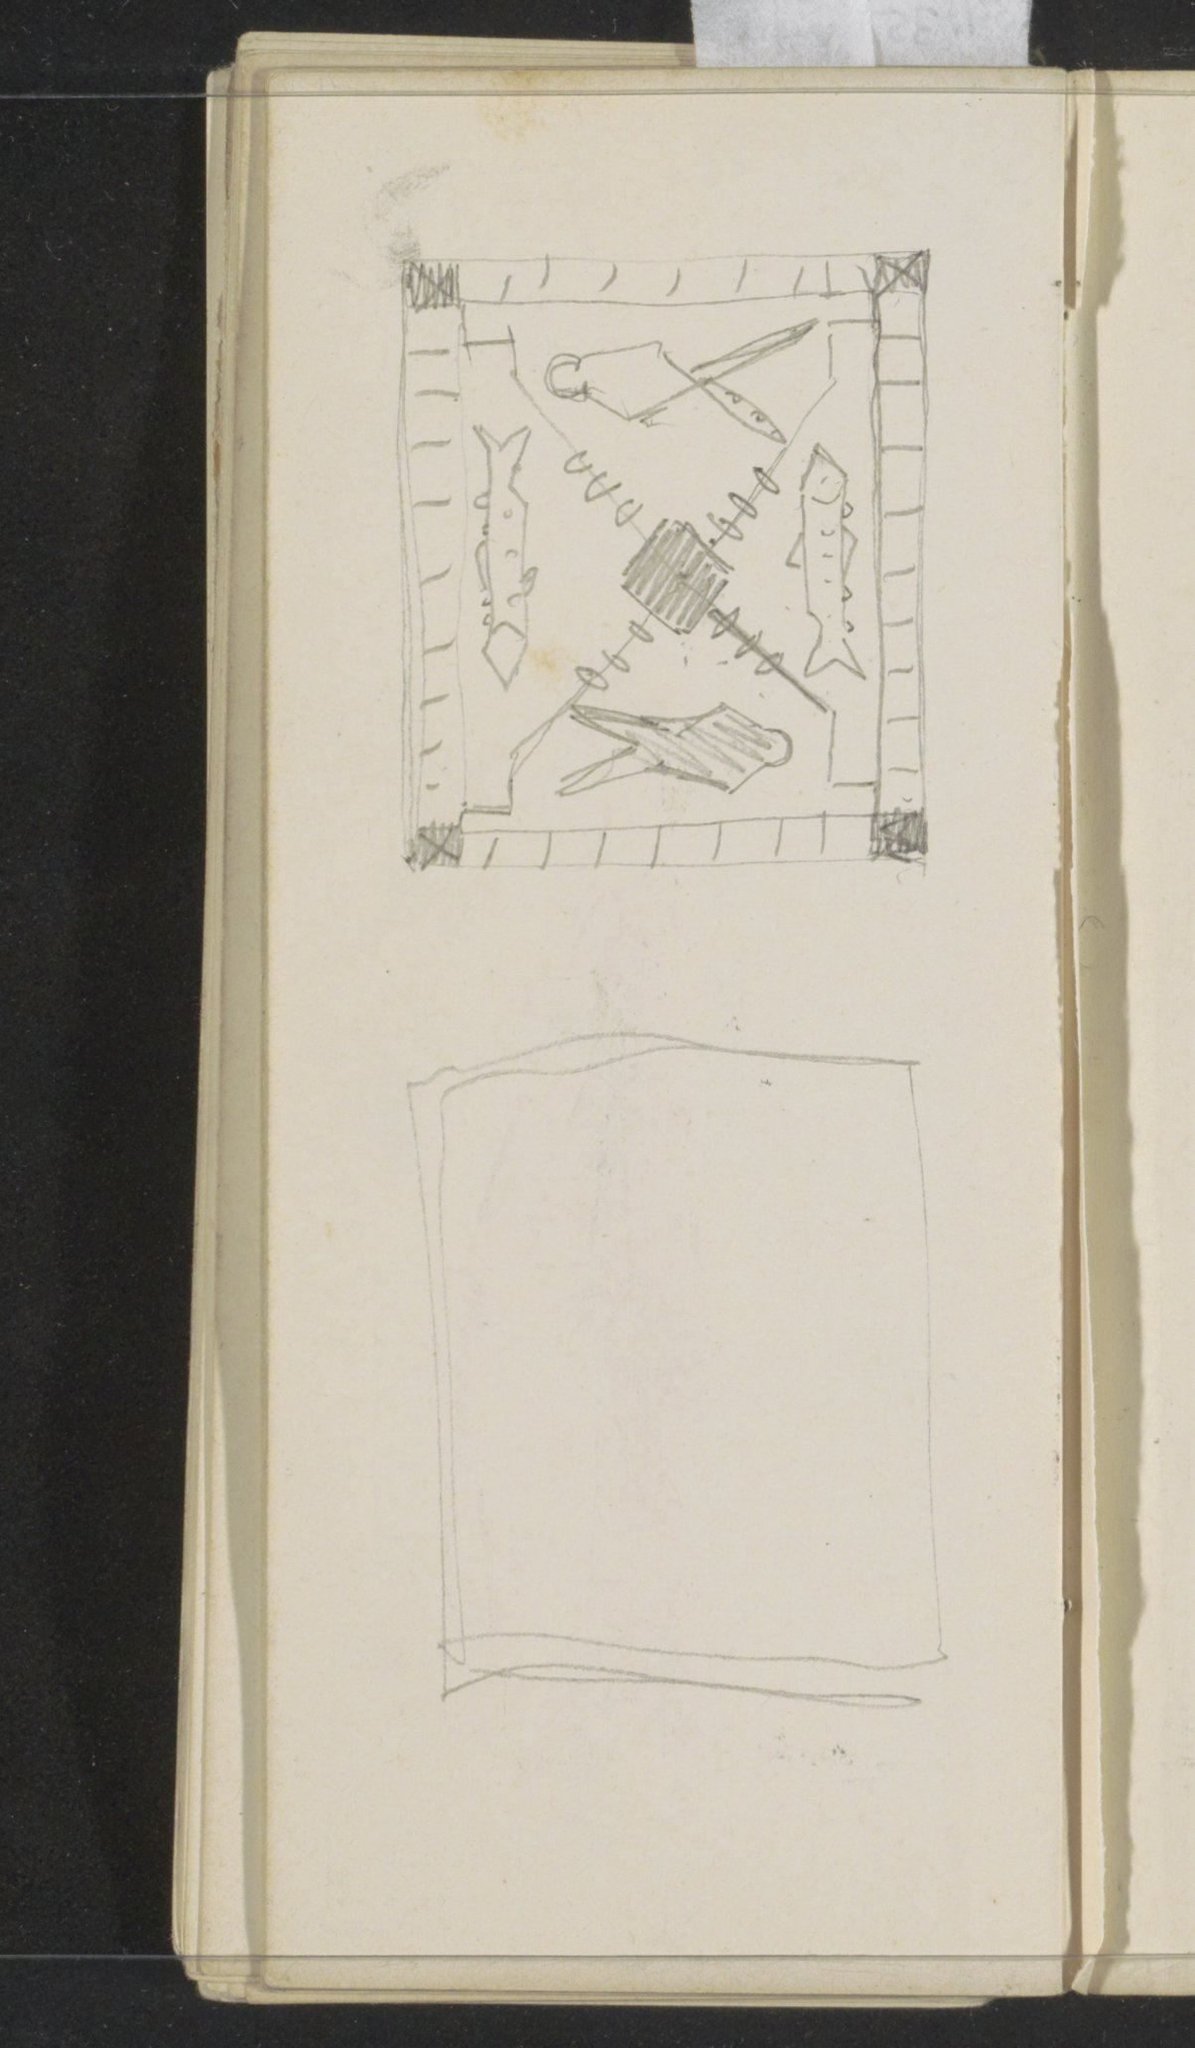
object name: sketchbook leaf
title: Ornament met vier vissen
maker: gerrit willem dijsselhof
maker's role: designer, draughtsman, print maker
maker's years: 1866-1924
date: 1901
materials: paper, pencil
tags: ornaments ~ art, fishes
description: Blad 41 verso uit een schetsboek met 42 bladzijden.